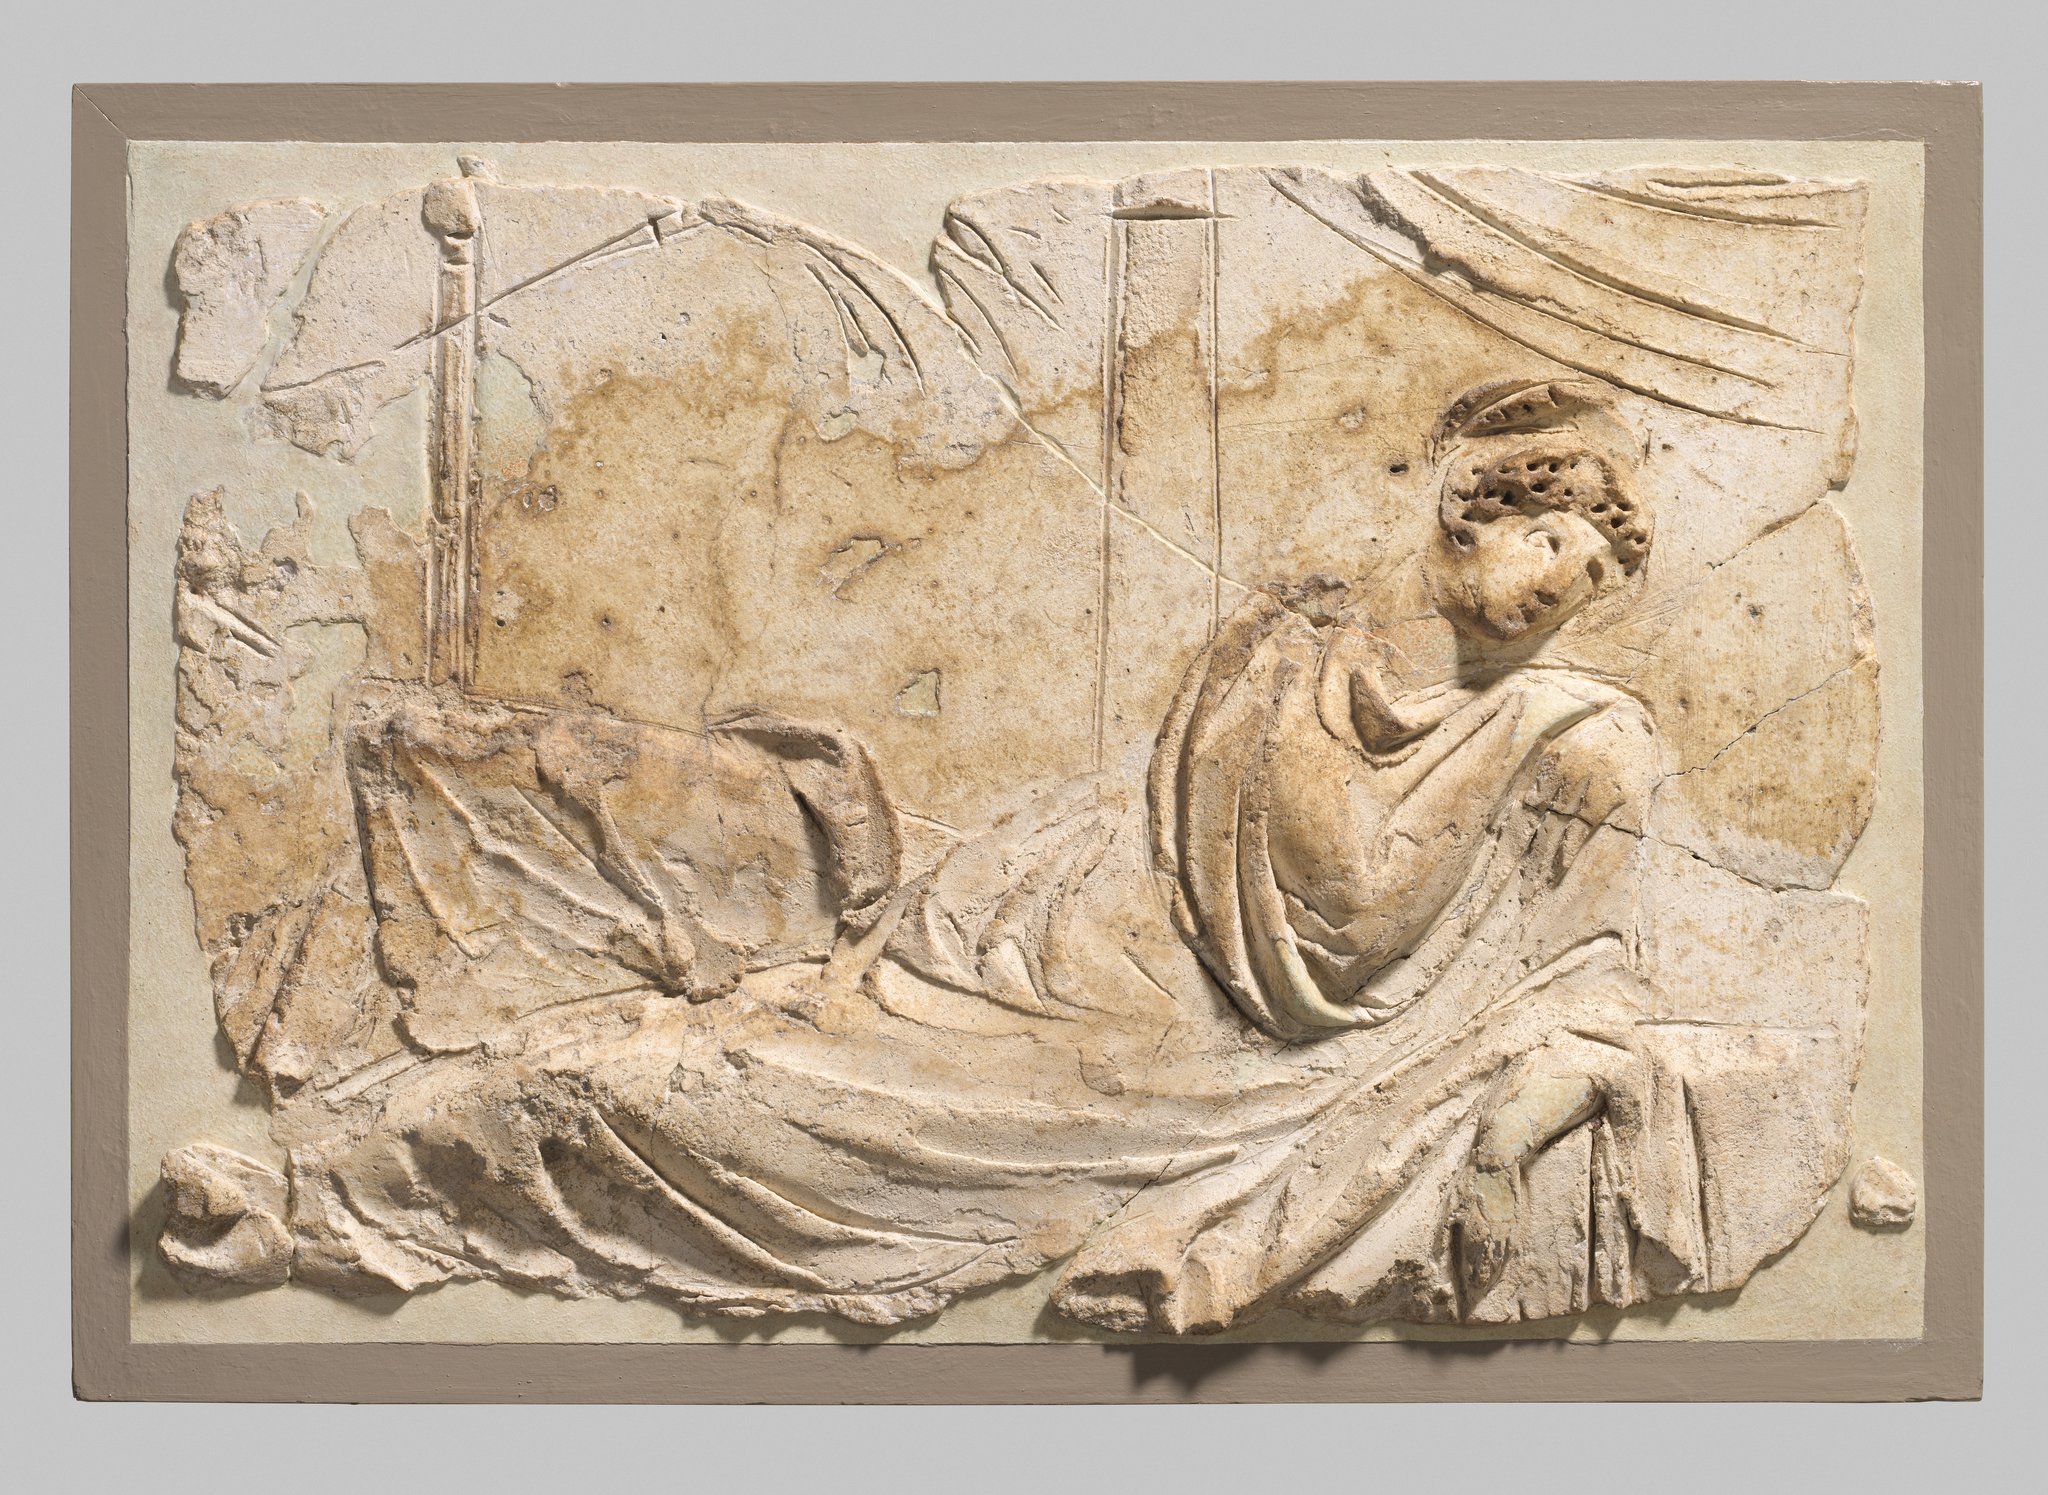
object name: stucco relief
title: Stucco relief panel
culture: roman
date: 51-100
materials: plaster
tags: women